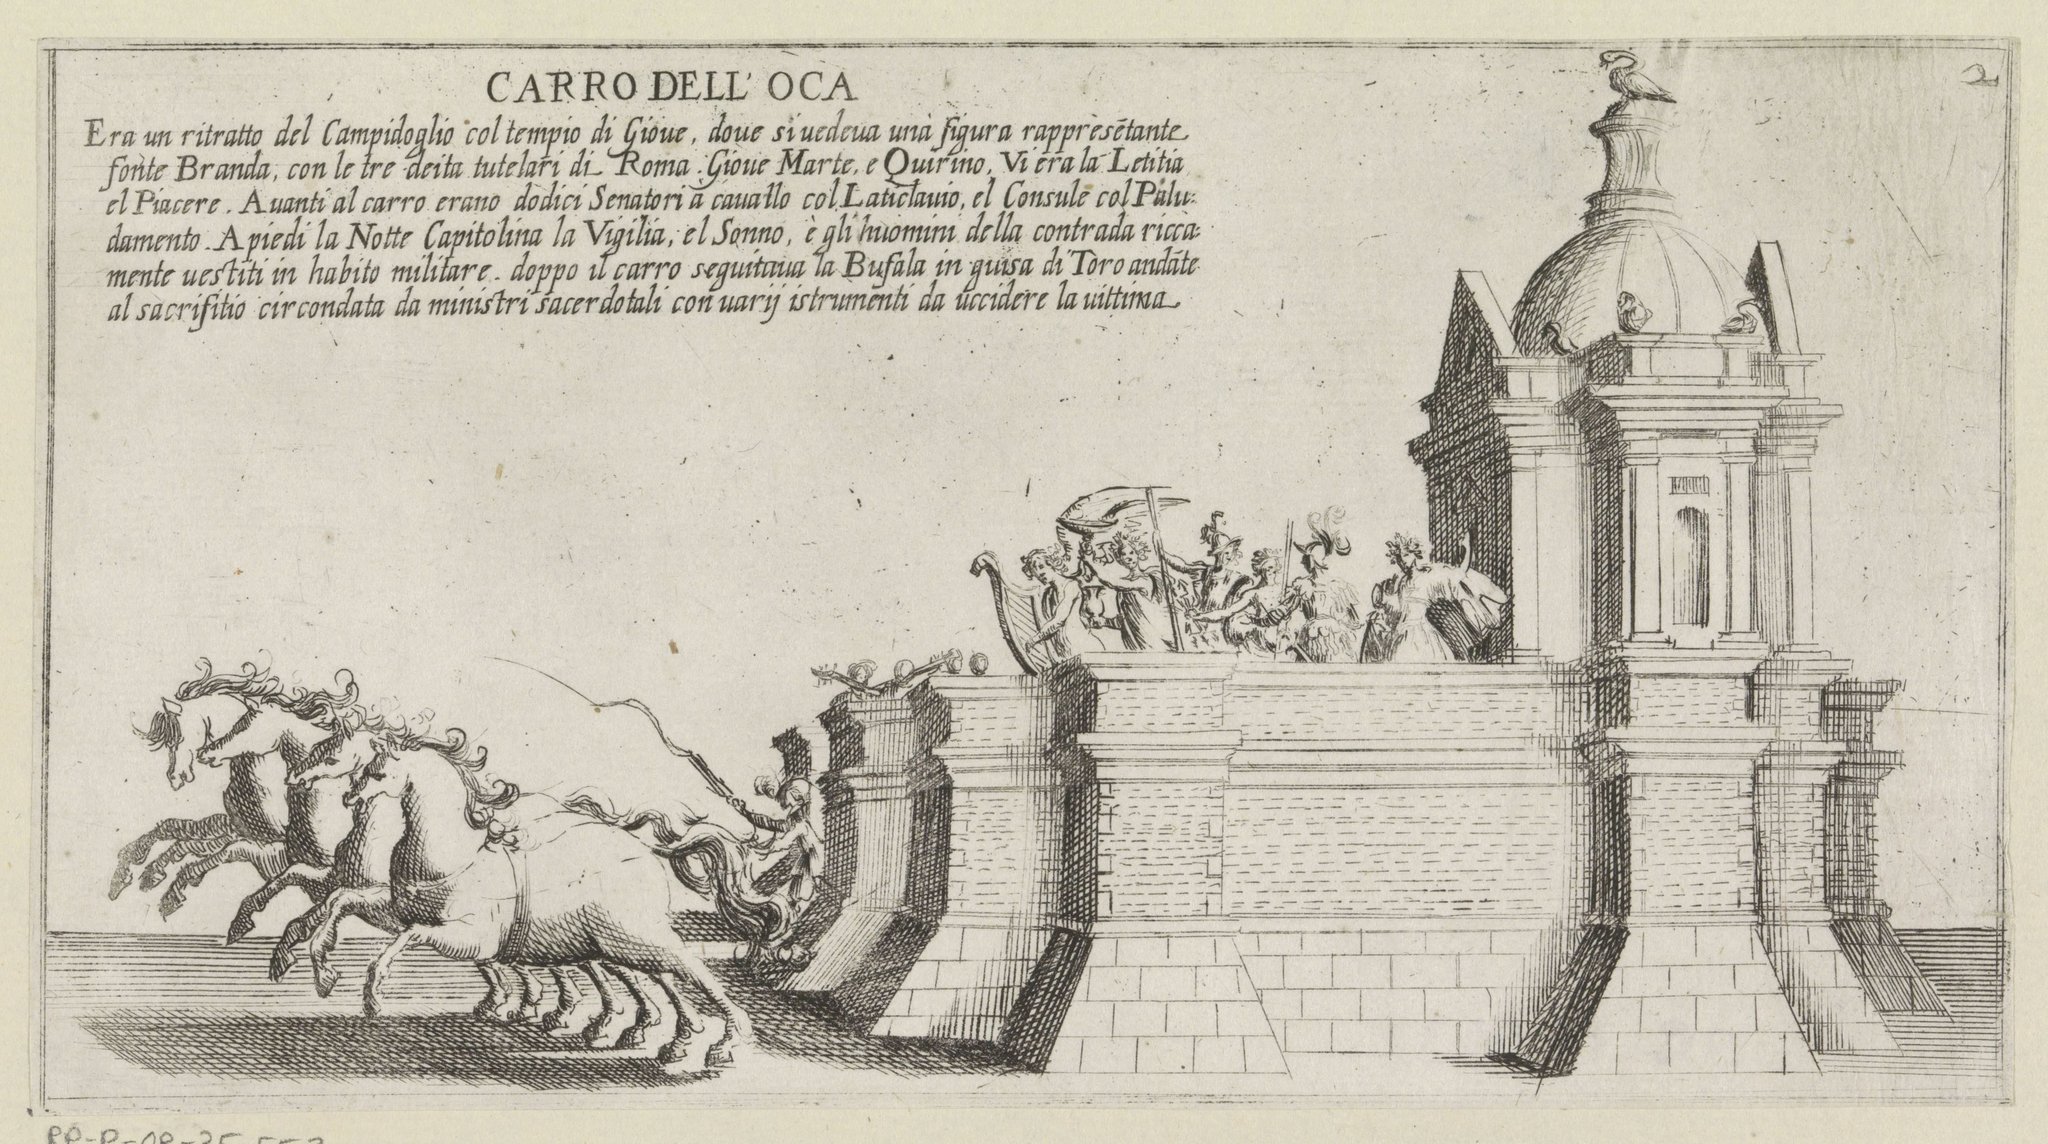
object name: print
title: Triomfwagens voor een festival in Siena in 1632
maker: bernardino capitelli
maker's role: print maker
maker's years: 1589-1640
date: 1632-1640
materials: paper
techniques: etching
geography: italy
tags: chariot, triumphal car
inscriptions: collector's mark: Lugt 240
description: De Triomfwagen van het Sienese district Occa die wordt getrokken door vier paarden. Bovenop de wagen staan een gebouw met een koepel, gevleugelde figuren en soldaten.